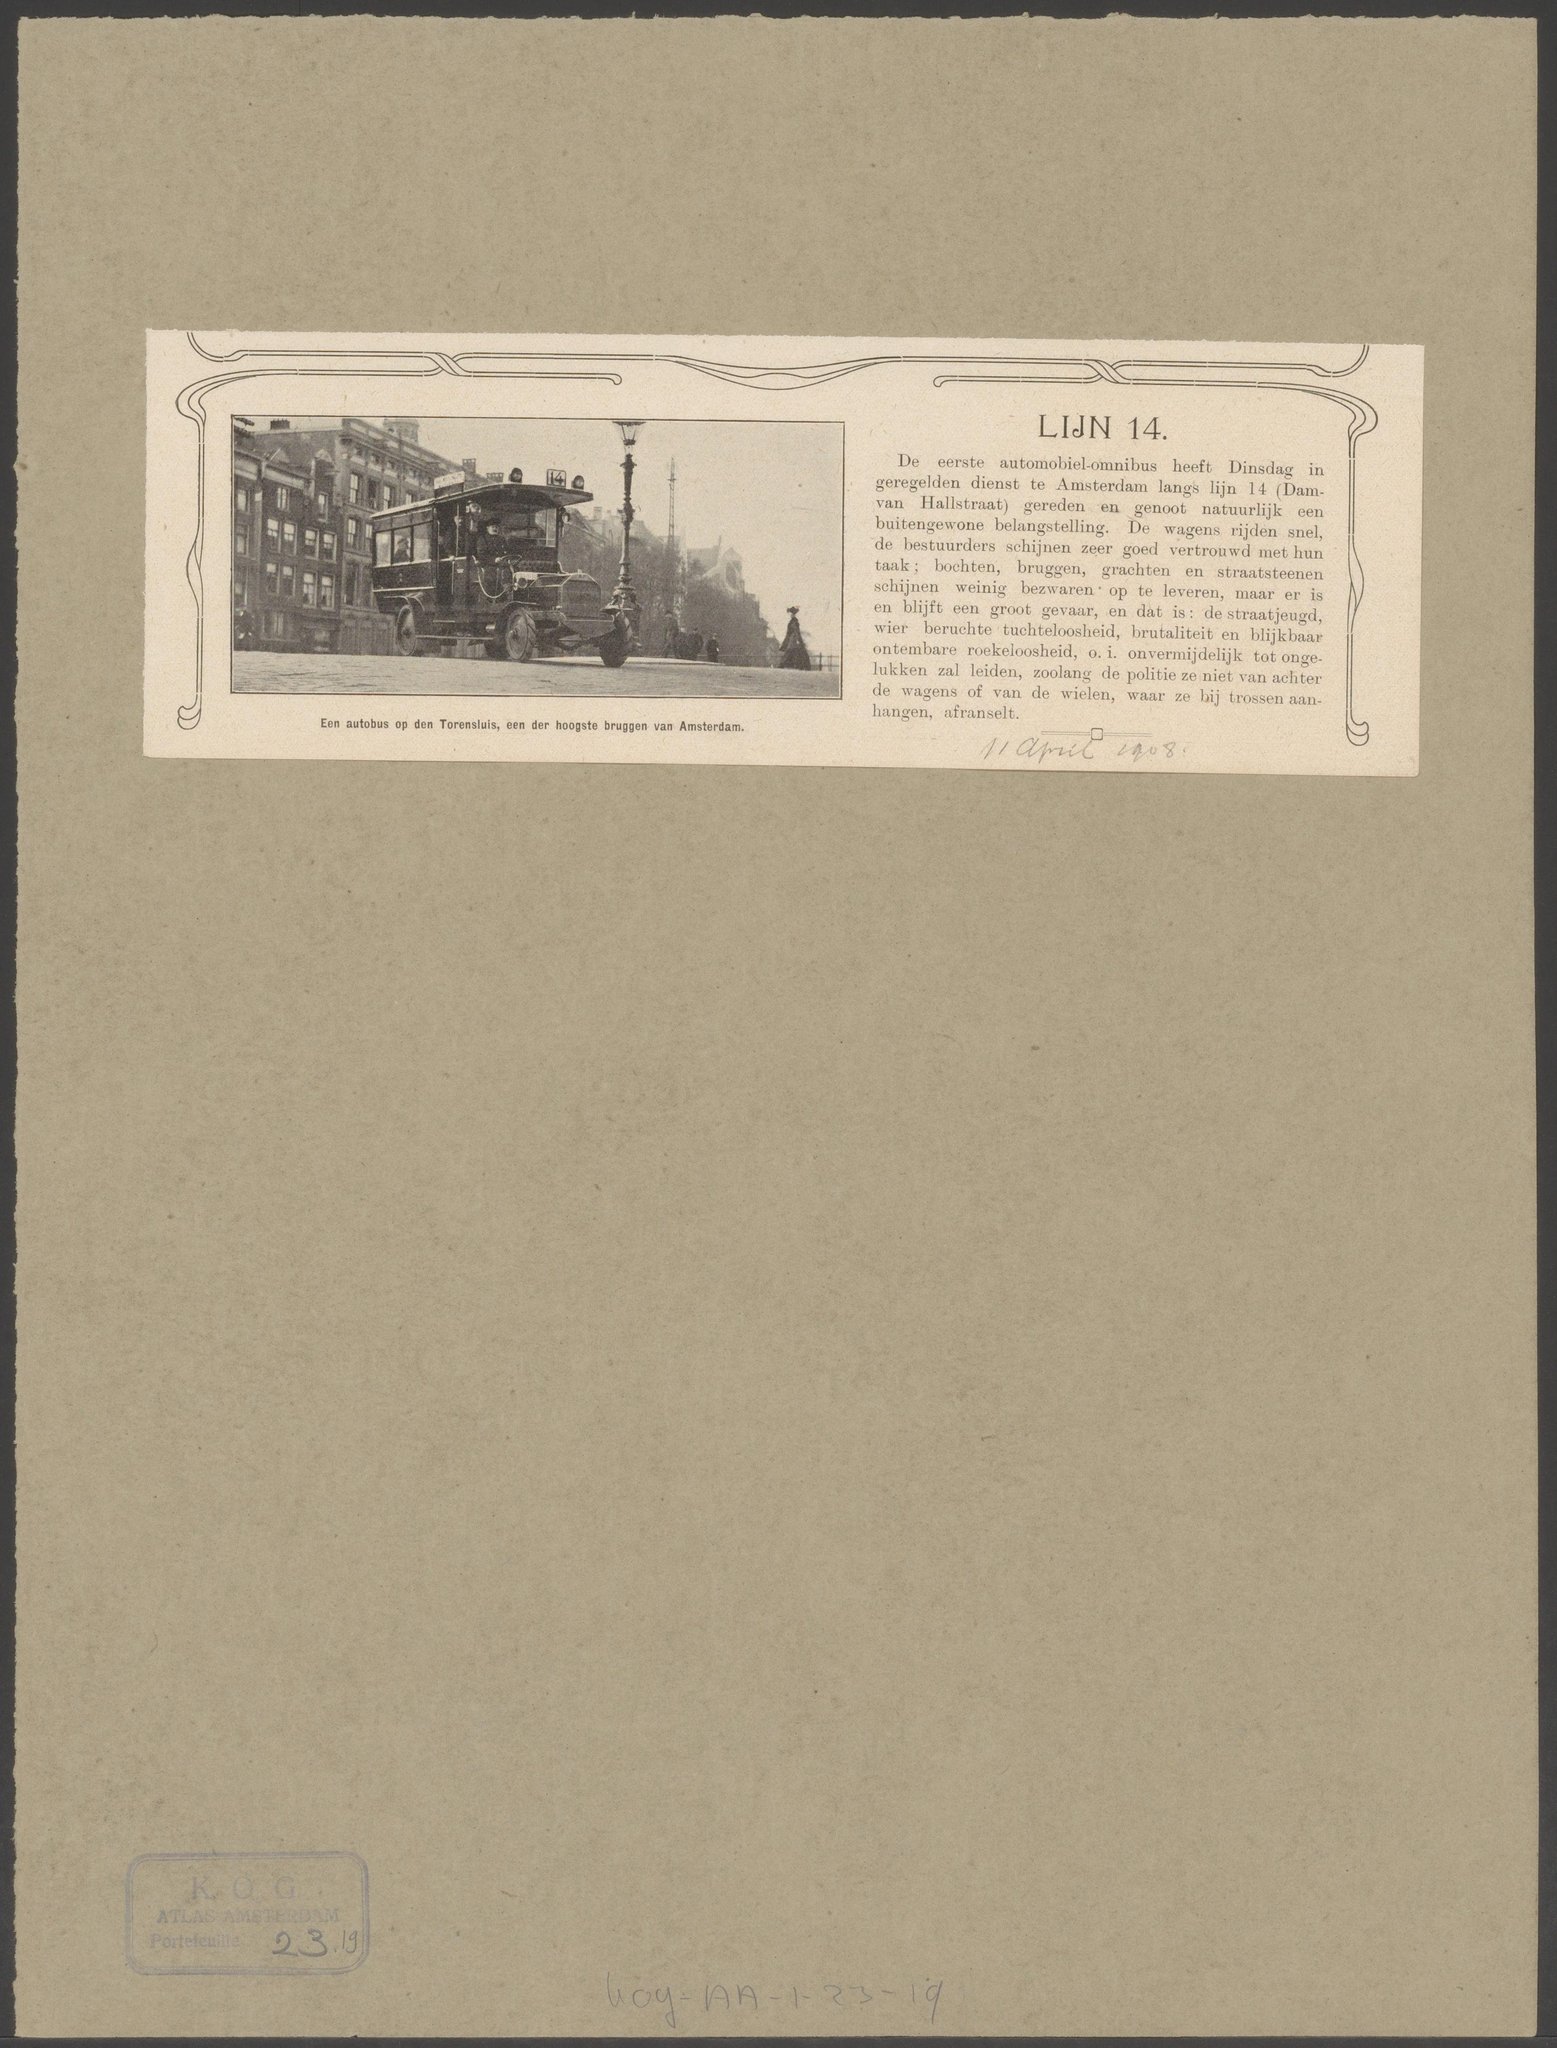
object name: photomechanical print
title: Motoromnibus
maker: Anonymous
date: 1908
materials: paper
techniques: letterpress printing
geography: amsterdam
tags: bus, coach, diligence, omnibus, horse-tram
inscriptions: collector's mark: Lugt 1641b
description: Onderwerpsrubriek binnen de Atlas Amsterdam: Gemeentebedrijven.